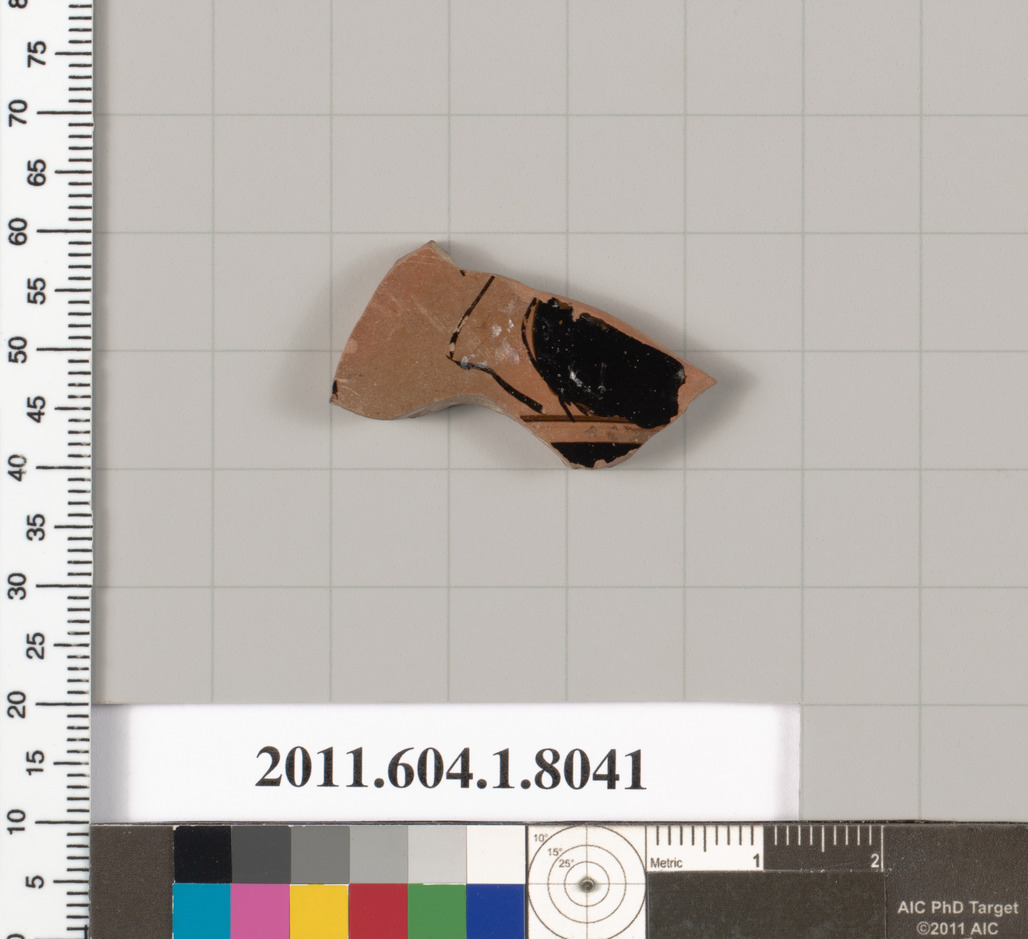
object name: kylix fragment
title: Terracotta fragment of a kylix (drinking cup)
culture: greek, attic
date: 510-500 BCE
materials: terracotta